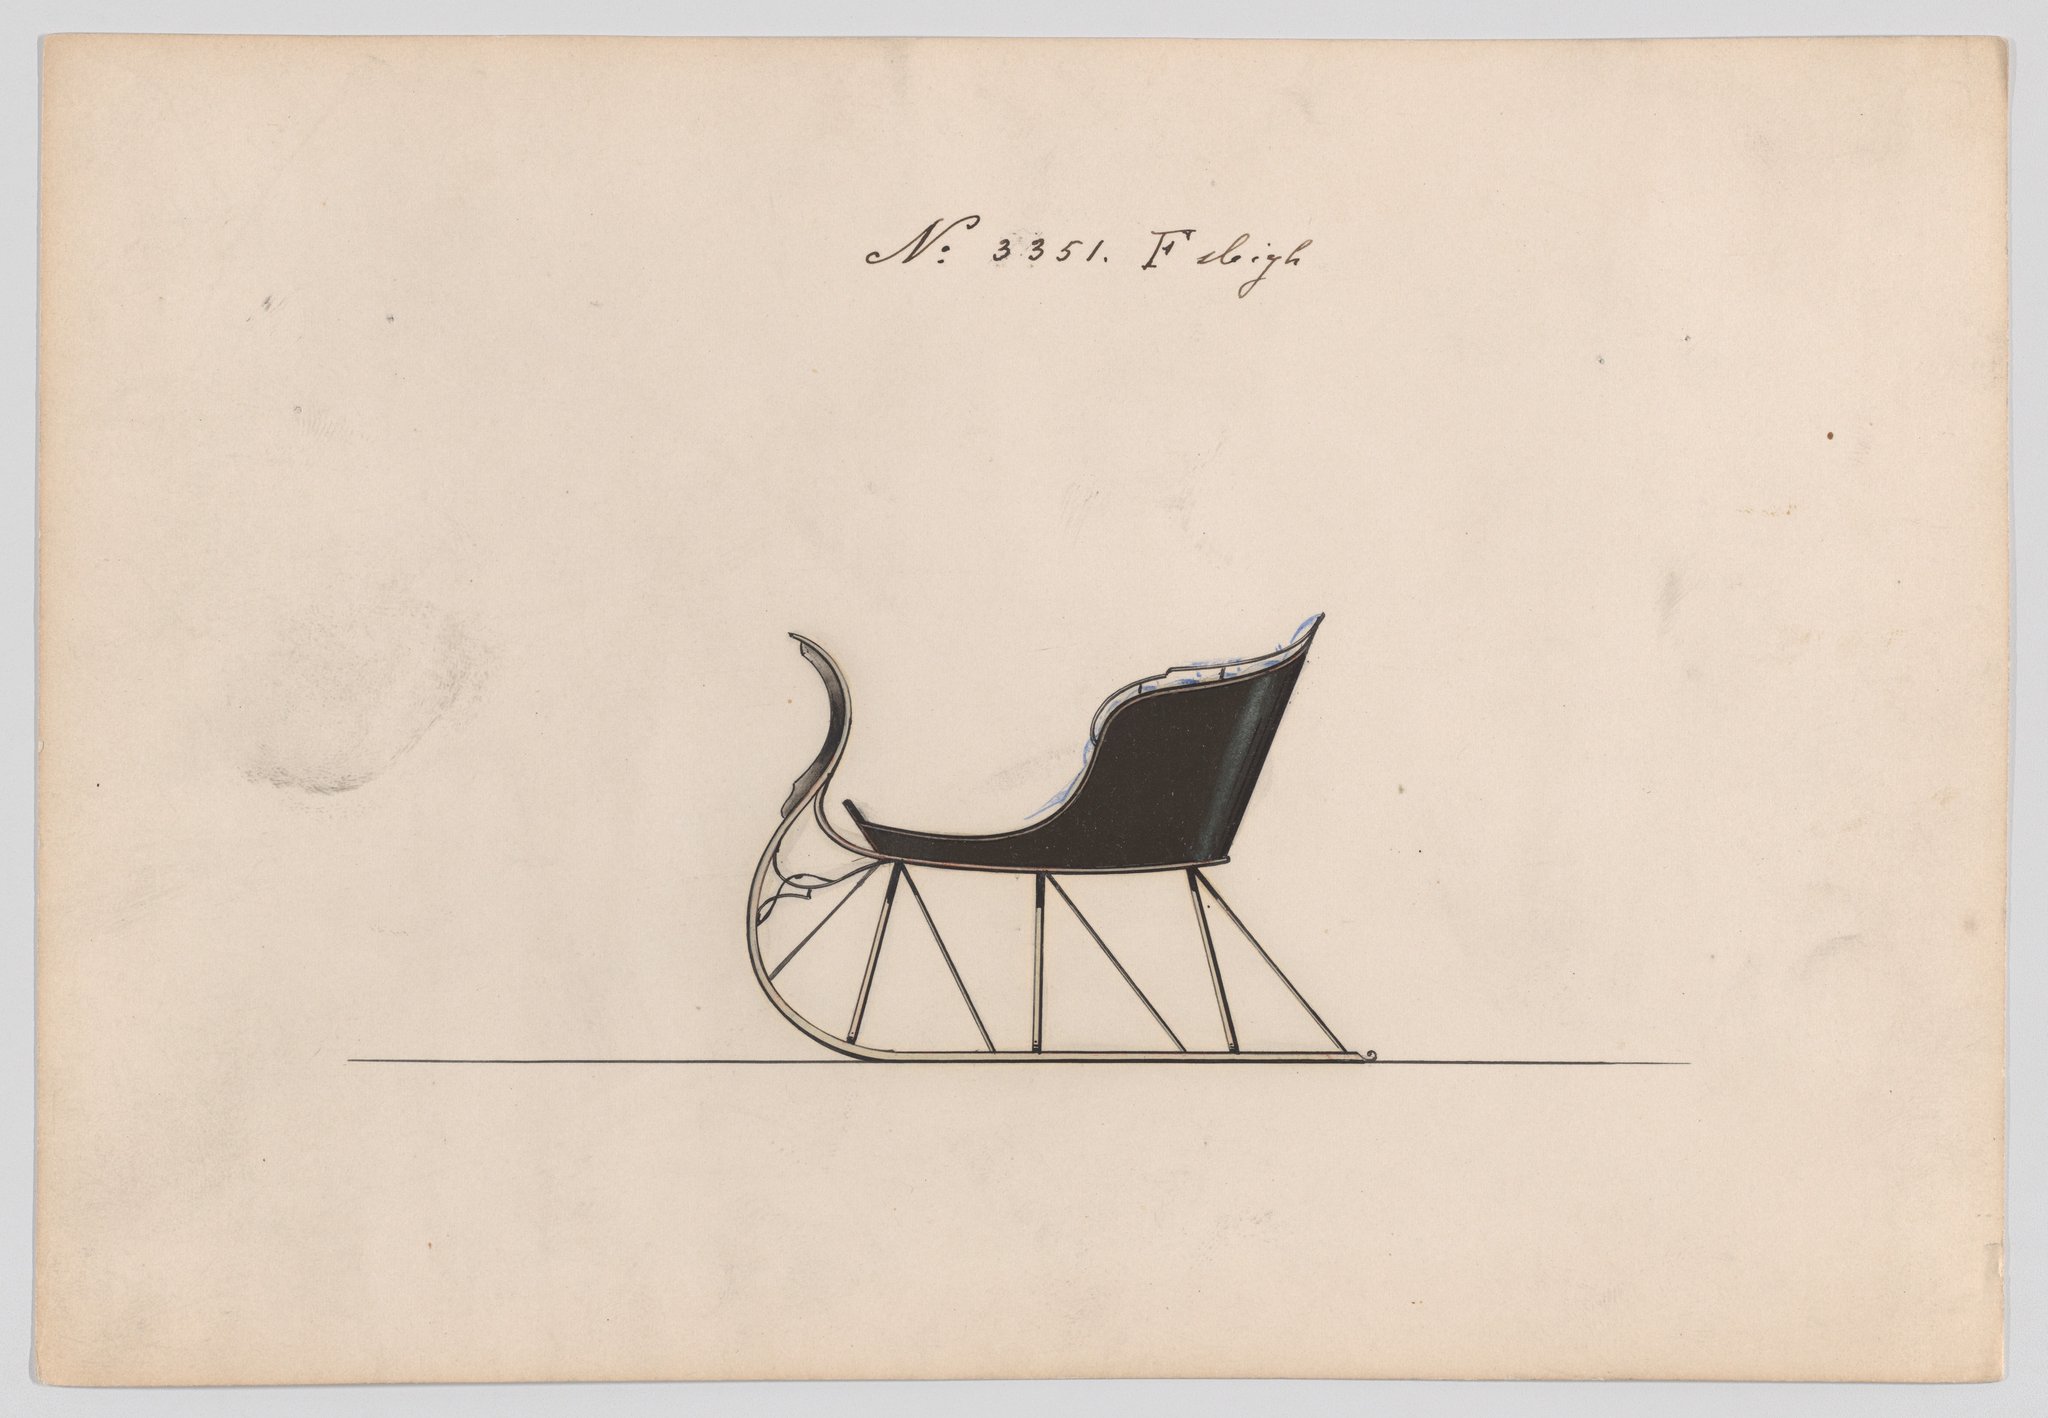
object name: drawing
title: Sleigh #3351 F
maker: brewster & co.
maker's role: manufacturer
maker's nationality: american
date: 1877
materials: gouache, gum arabic, ink, watercolor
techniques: pen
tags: sleighs